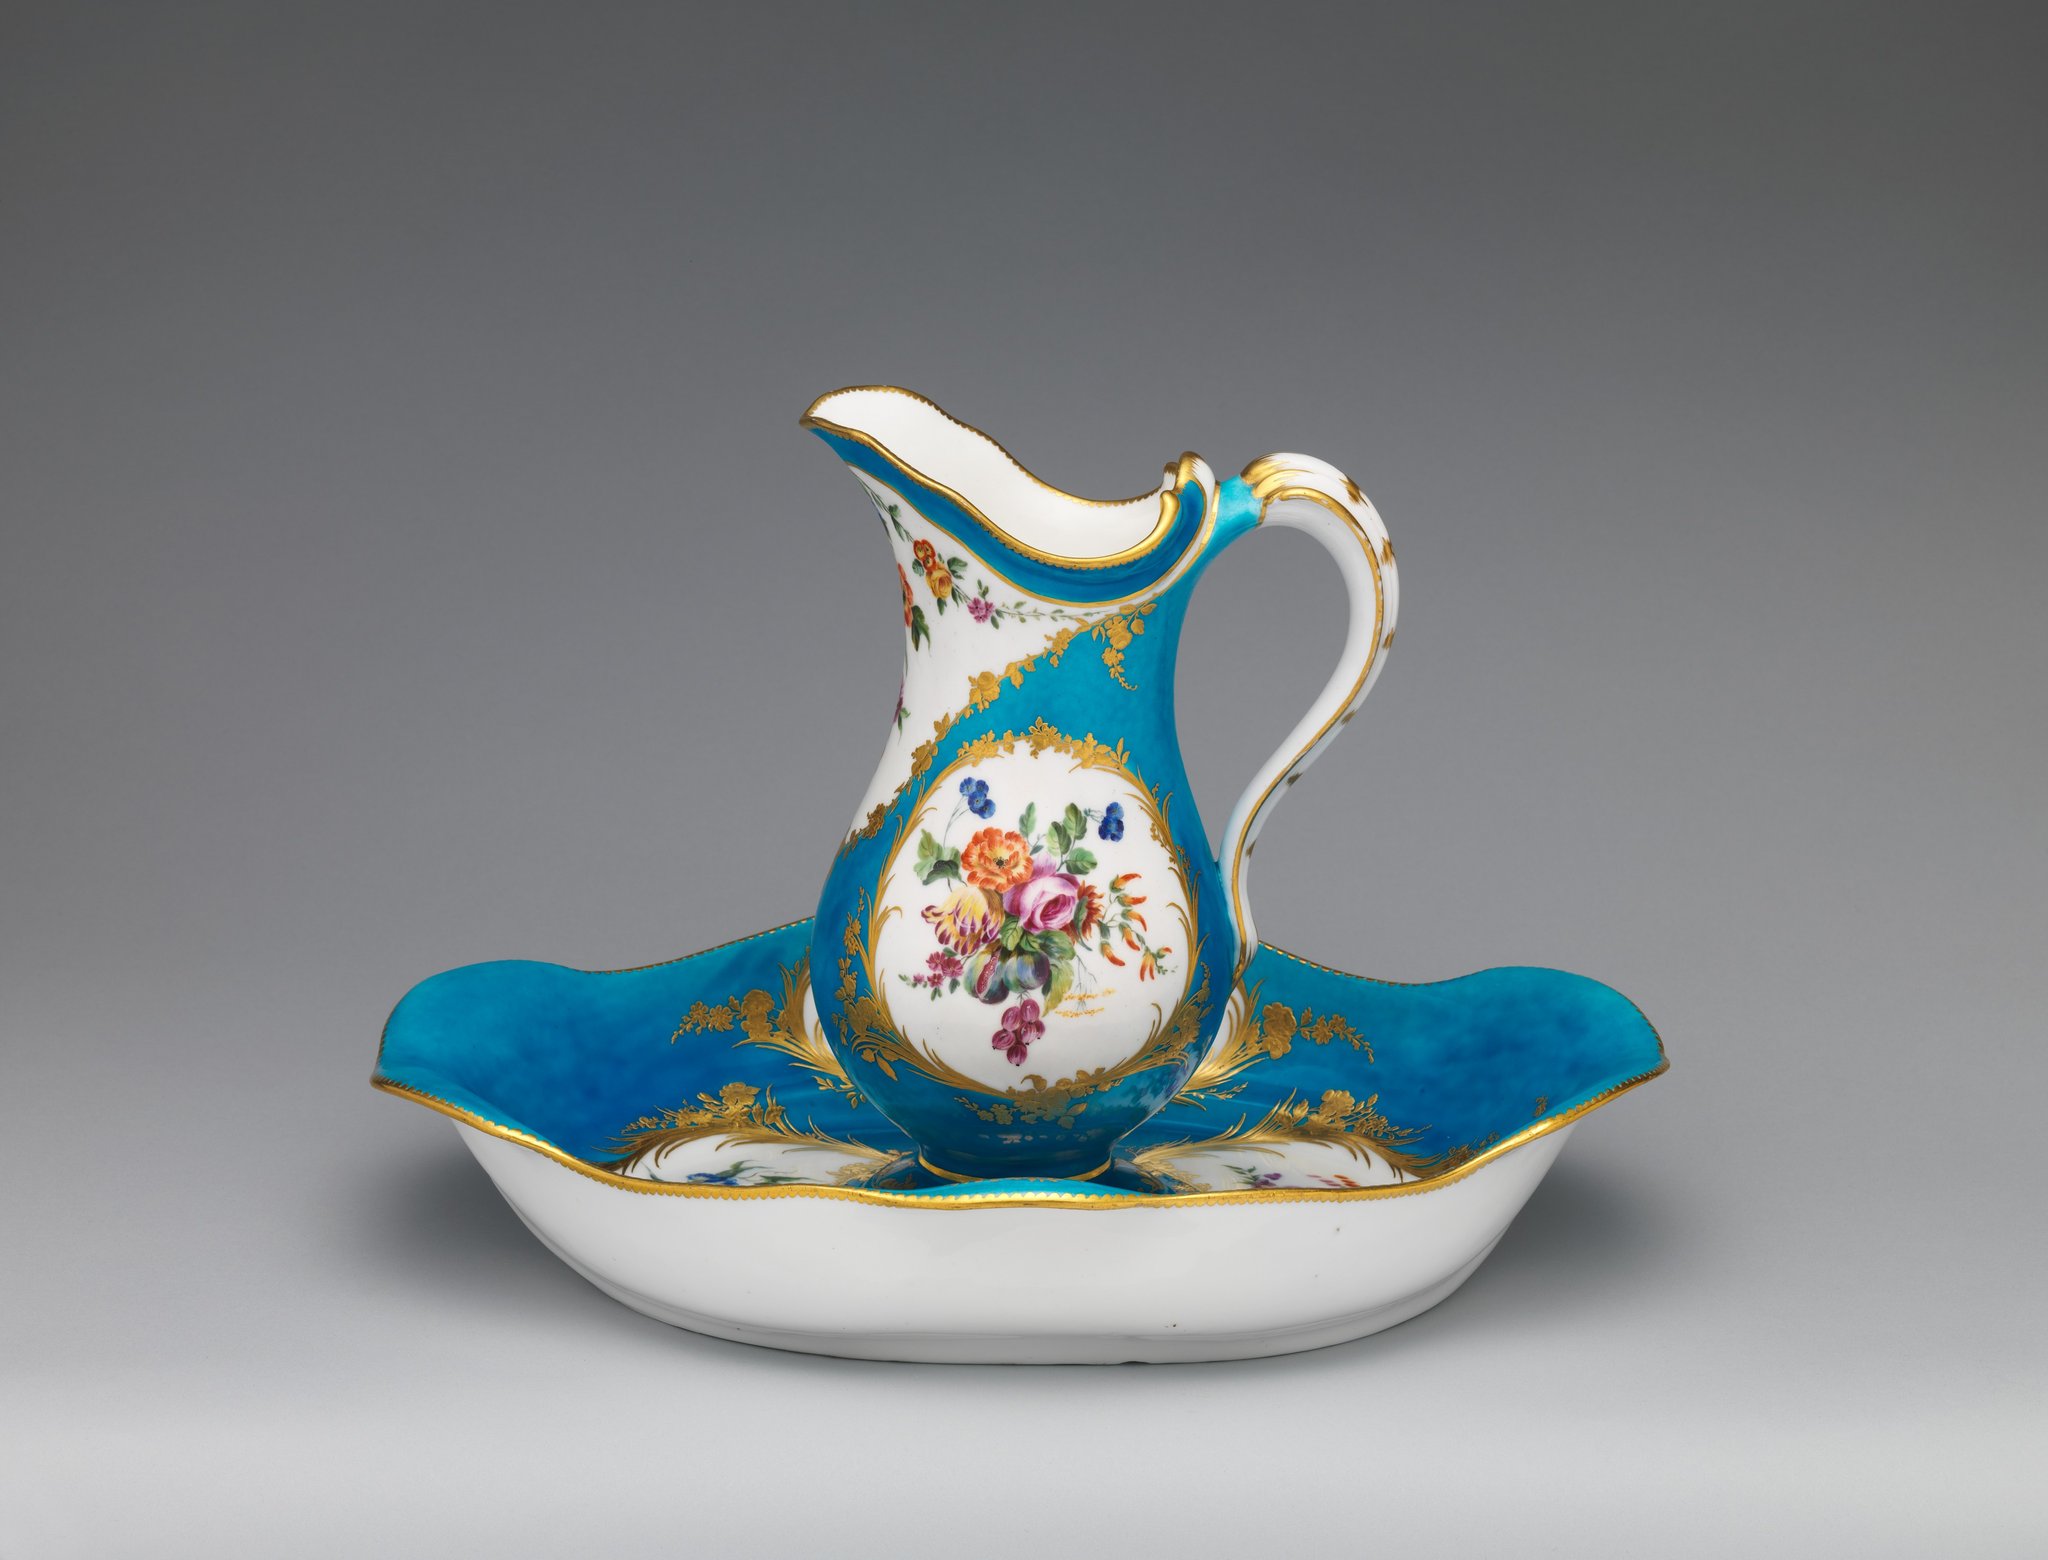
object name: ewer and basin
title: Ewer and basin (pot à la Romaine uni et jatte ovale)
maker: vincennes manufactory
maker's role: manufactory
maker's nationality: french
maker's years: 1740-1756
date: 1754-1755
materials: soft paste porcelain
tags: flowers,leaves